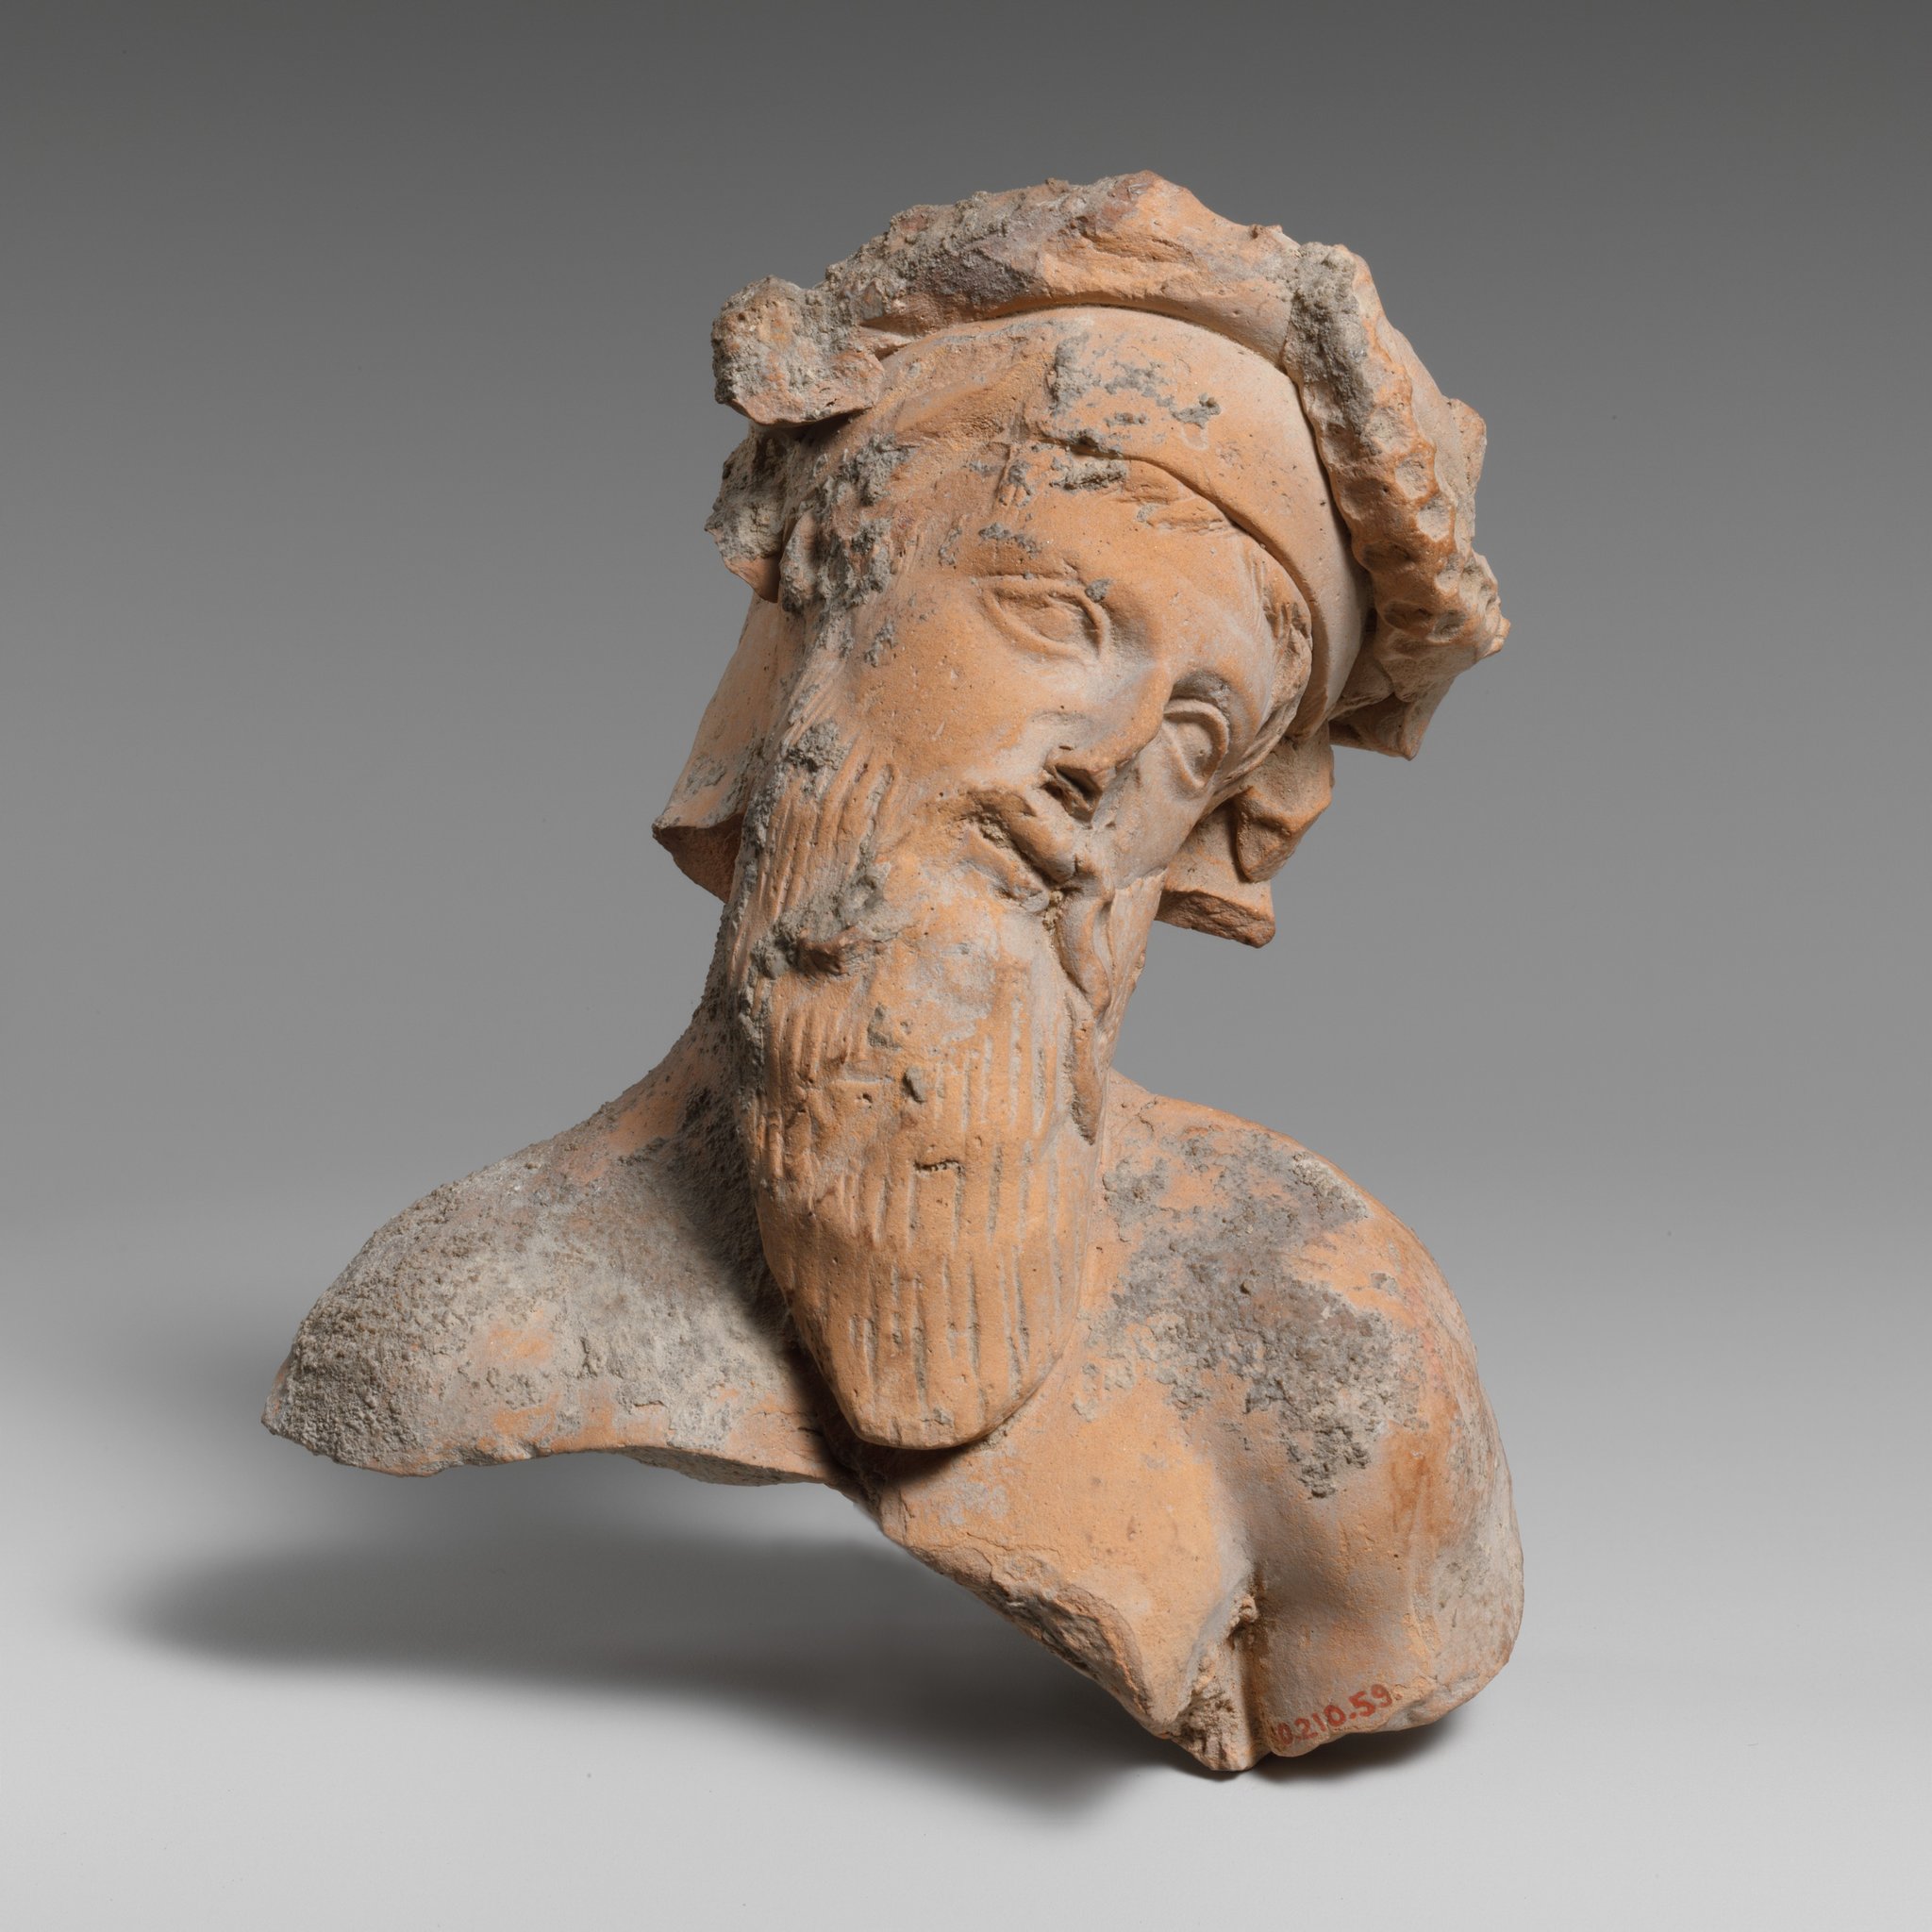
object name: head of dionysos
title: Terracotta fragment with the upper body of a bearded man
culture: greek, south italian, tarentine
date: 400-301 BCE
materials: terracotta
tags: heads,men